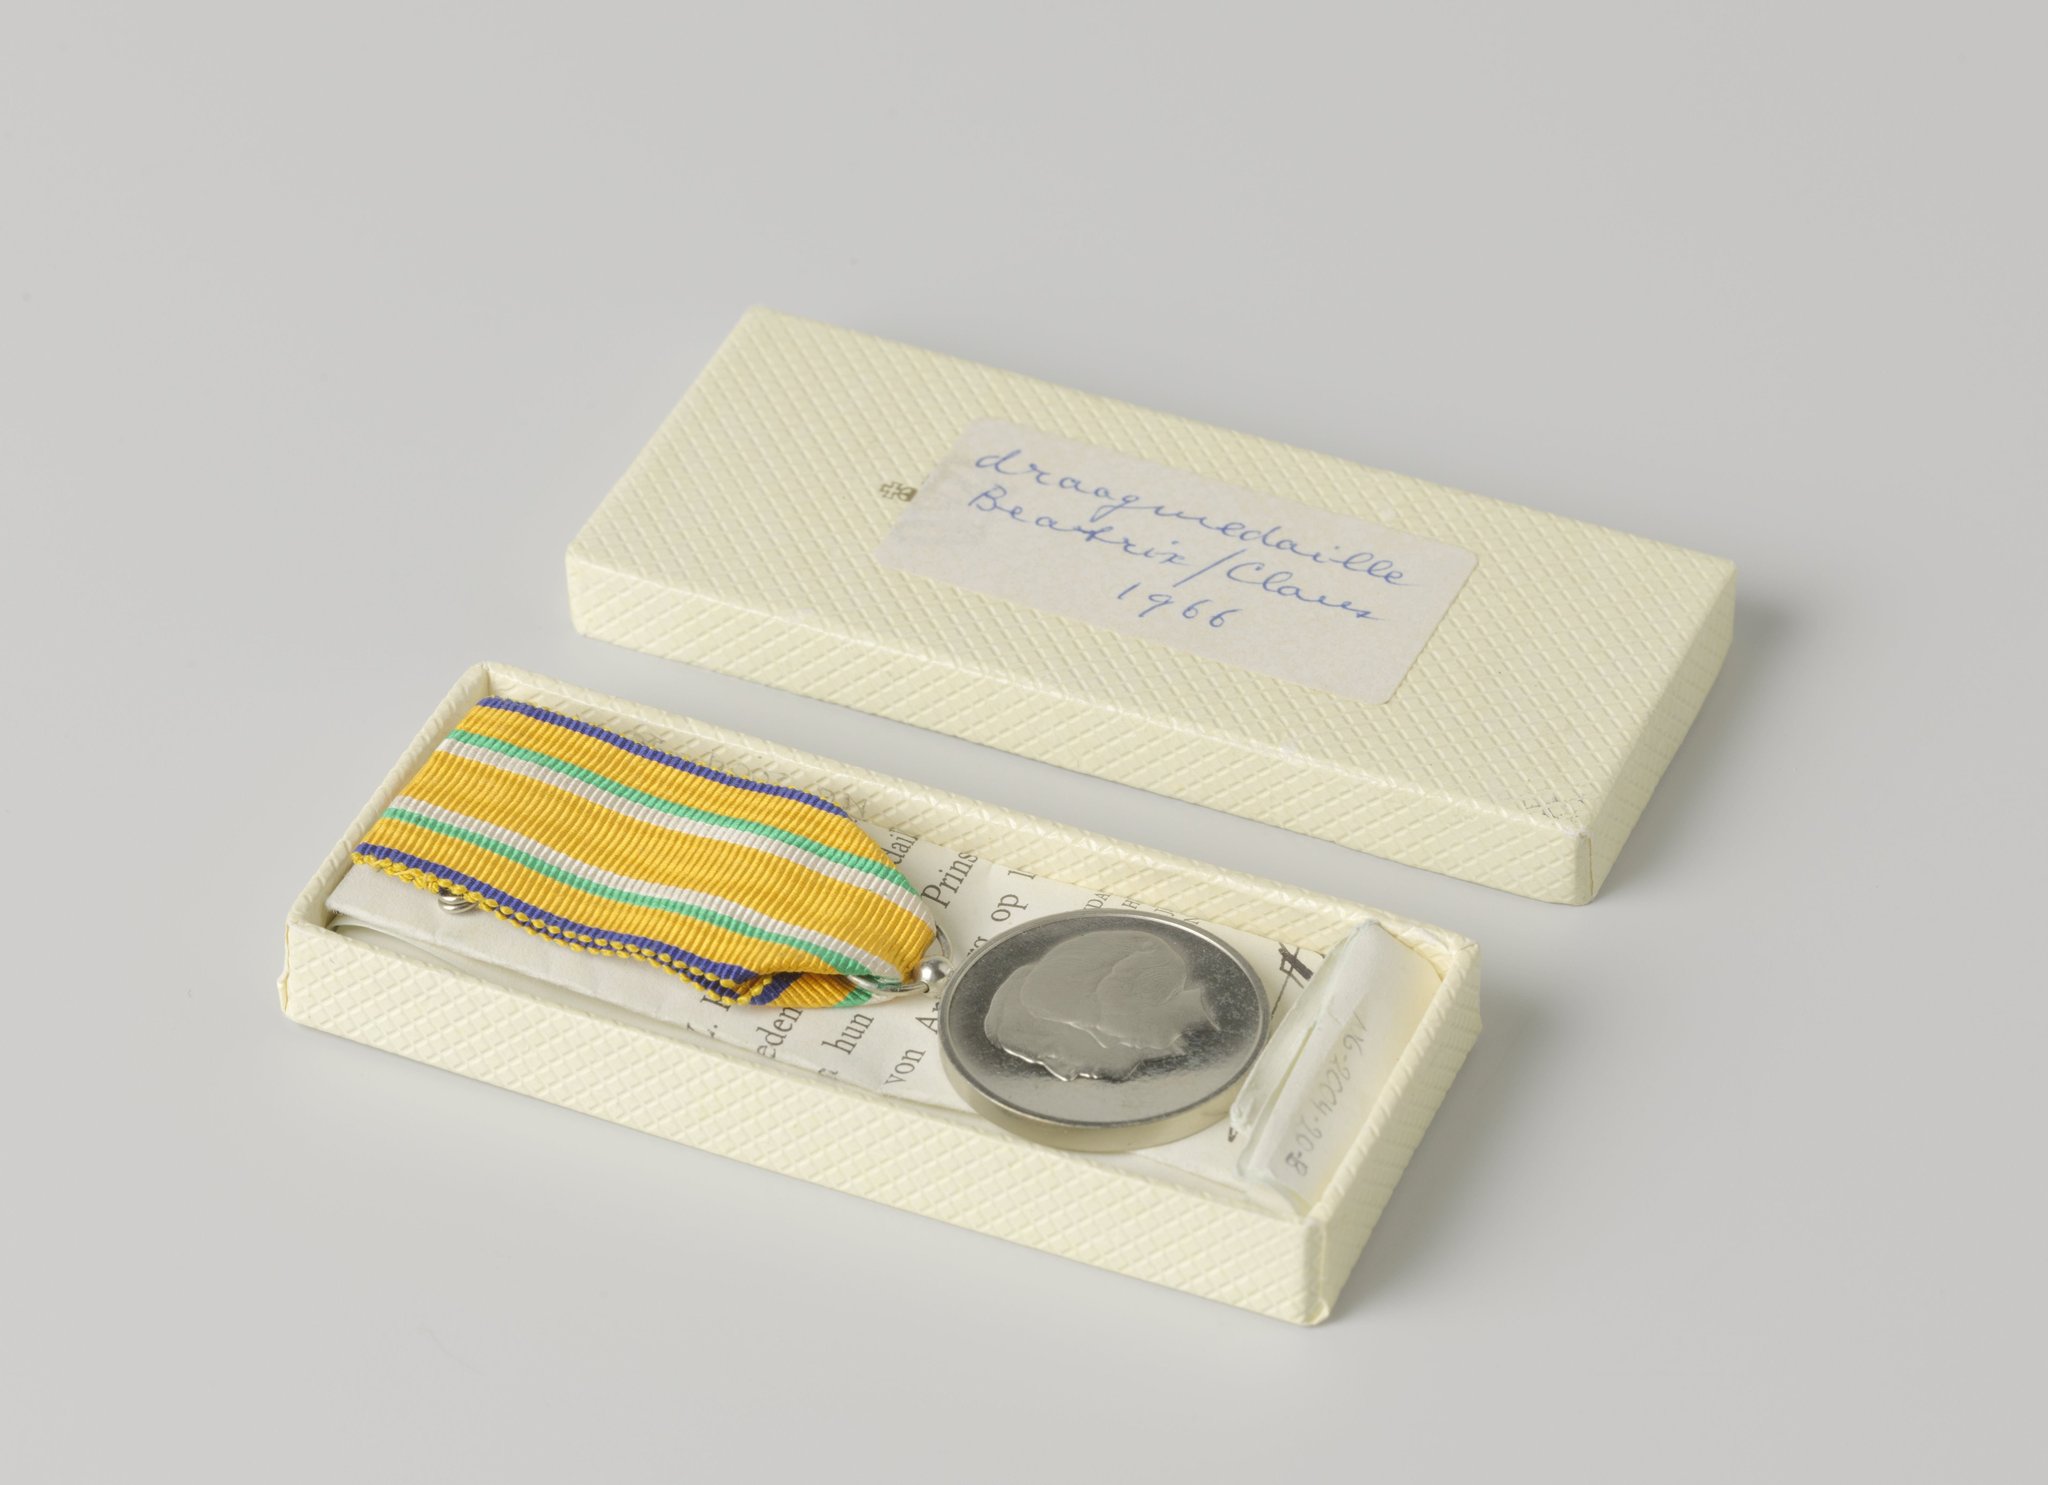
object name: marriage medal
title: Huwelijkspenning van huwelijk prinses Beatrix en Claus von Amsberg, 1966 met brief en doosje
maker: Anonymous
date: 1903-1966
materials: cardboard, paper, silver, textile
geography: netherlands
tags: beatrix (koningin der nederlanden), amsterdam, willem drees, netherlands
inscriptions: inscription: ‘CB’, date: ‘10 MAART 1966’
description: Onderscheiding, gegeven aan W. Drees vanwege zijn persoonlijke betrokkenheid bij het huwelijk van Beatrix en Claus, 10 maart 1966; Drees was een van de getuigen.